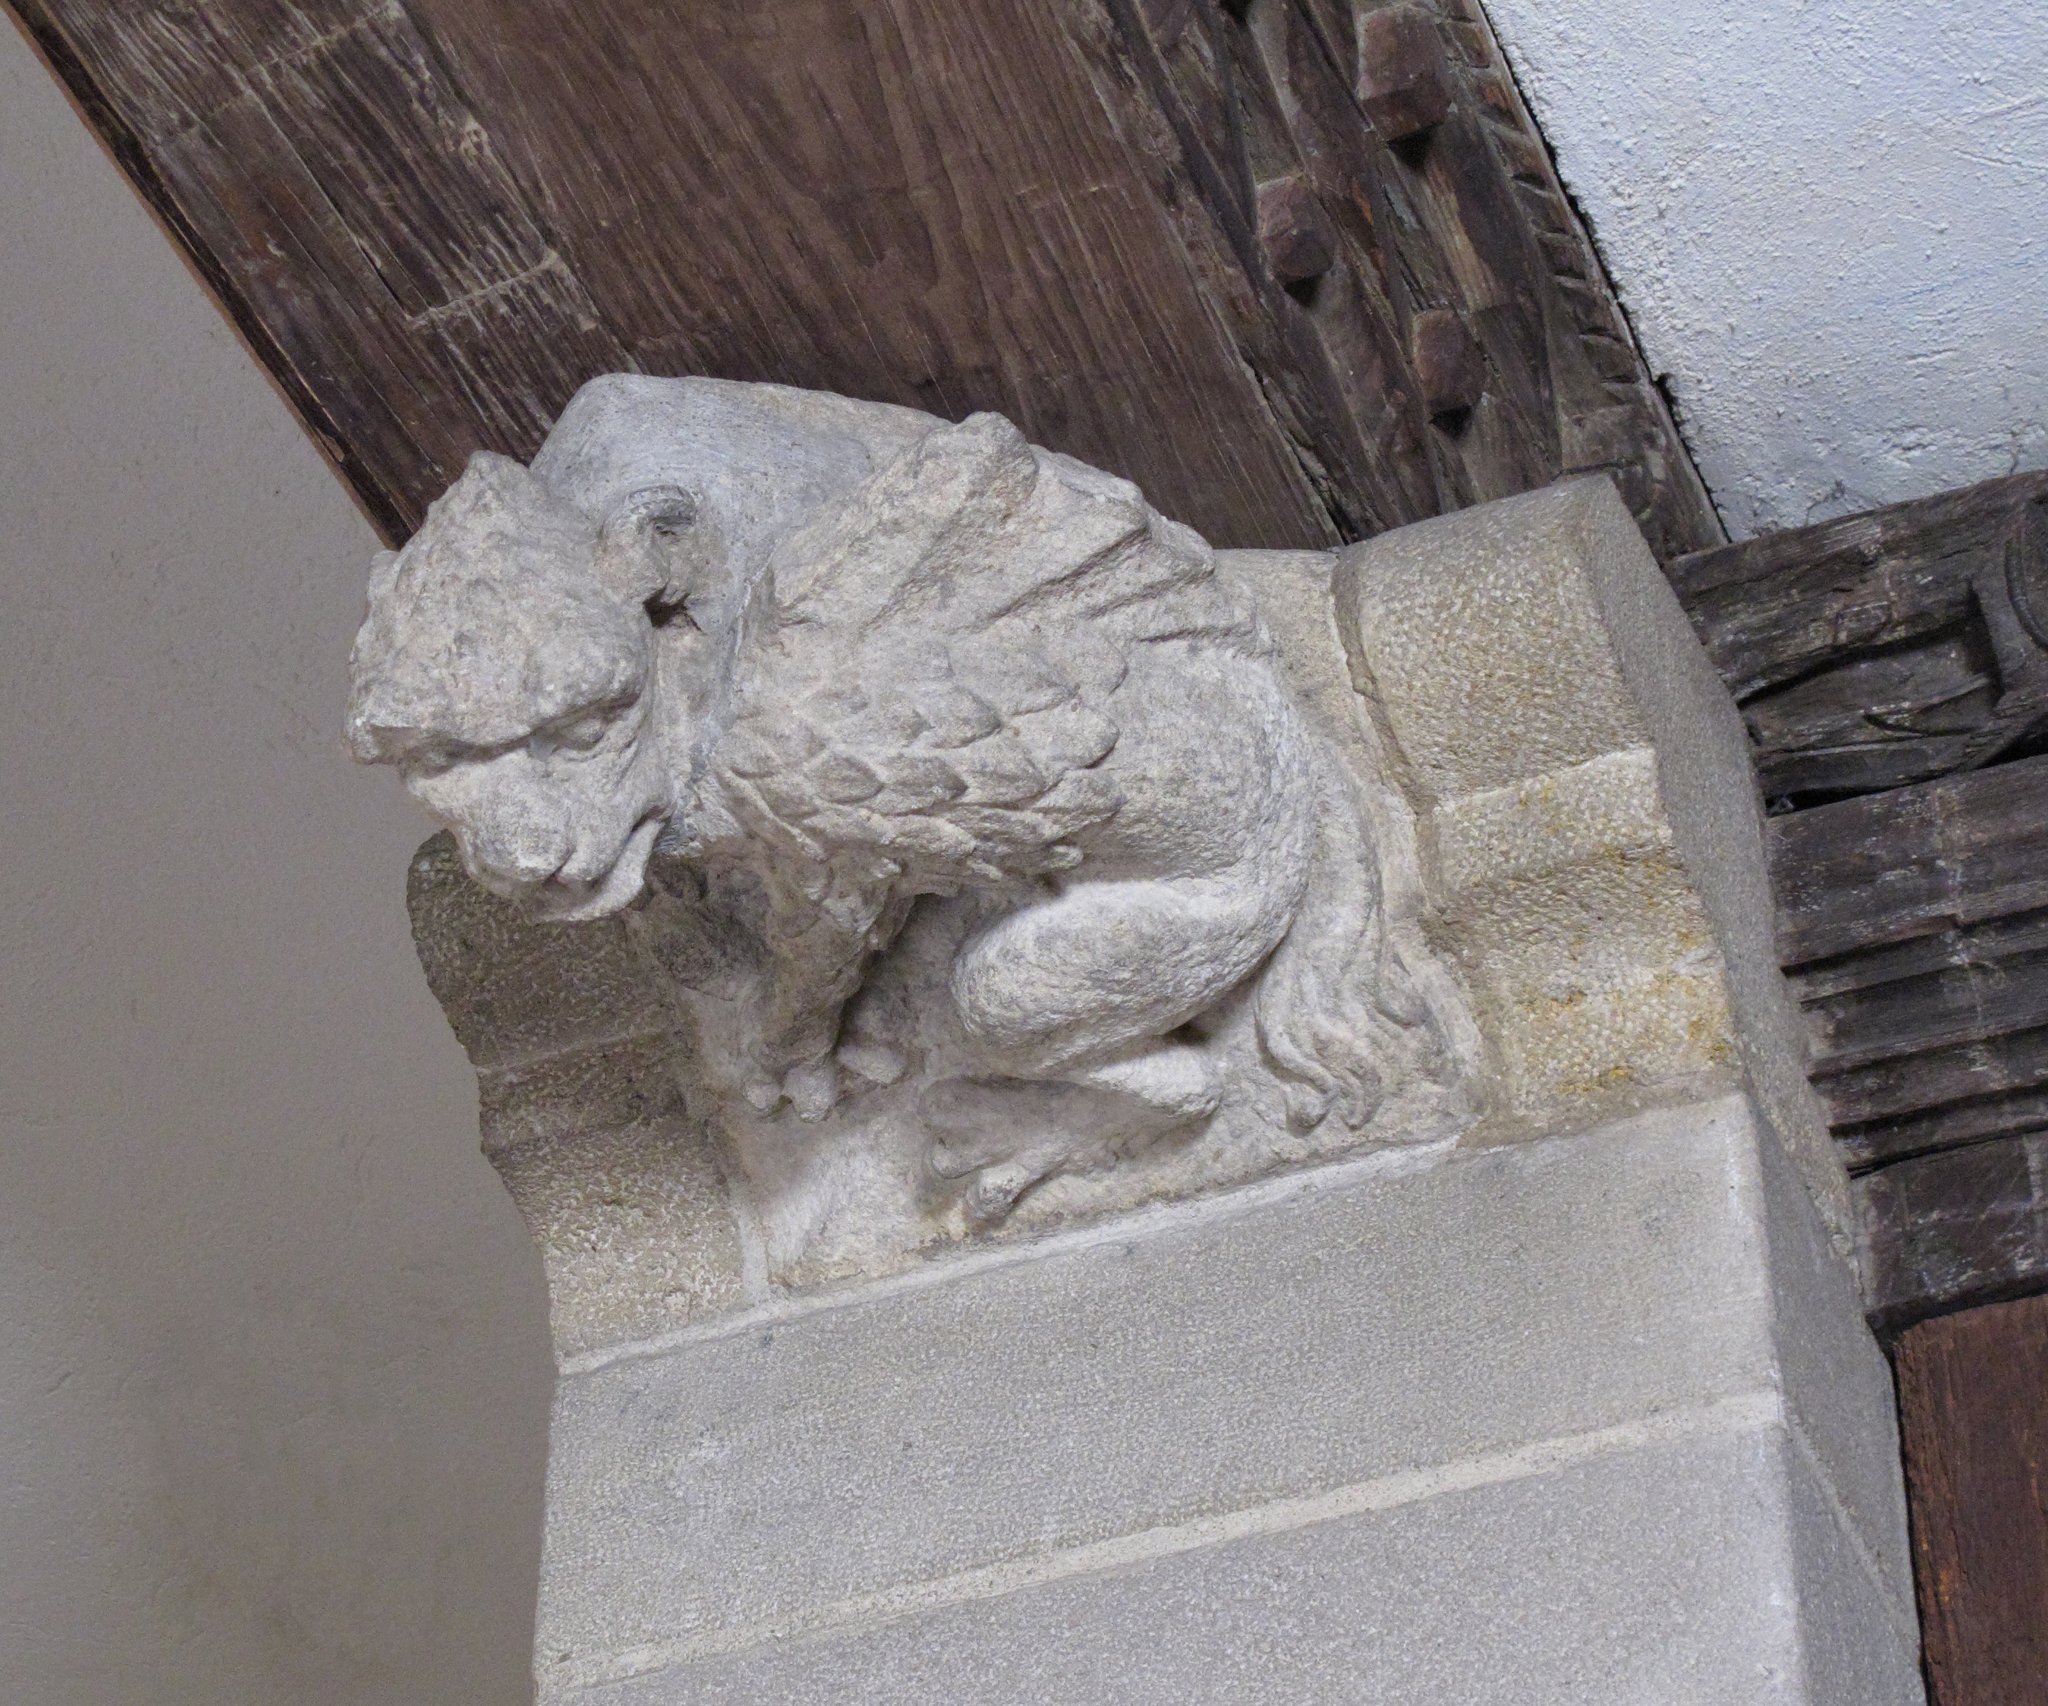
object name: corbel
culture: french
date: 1401-1500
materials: limestone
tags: griffins